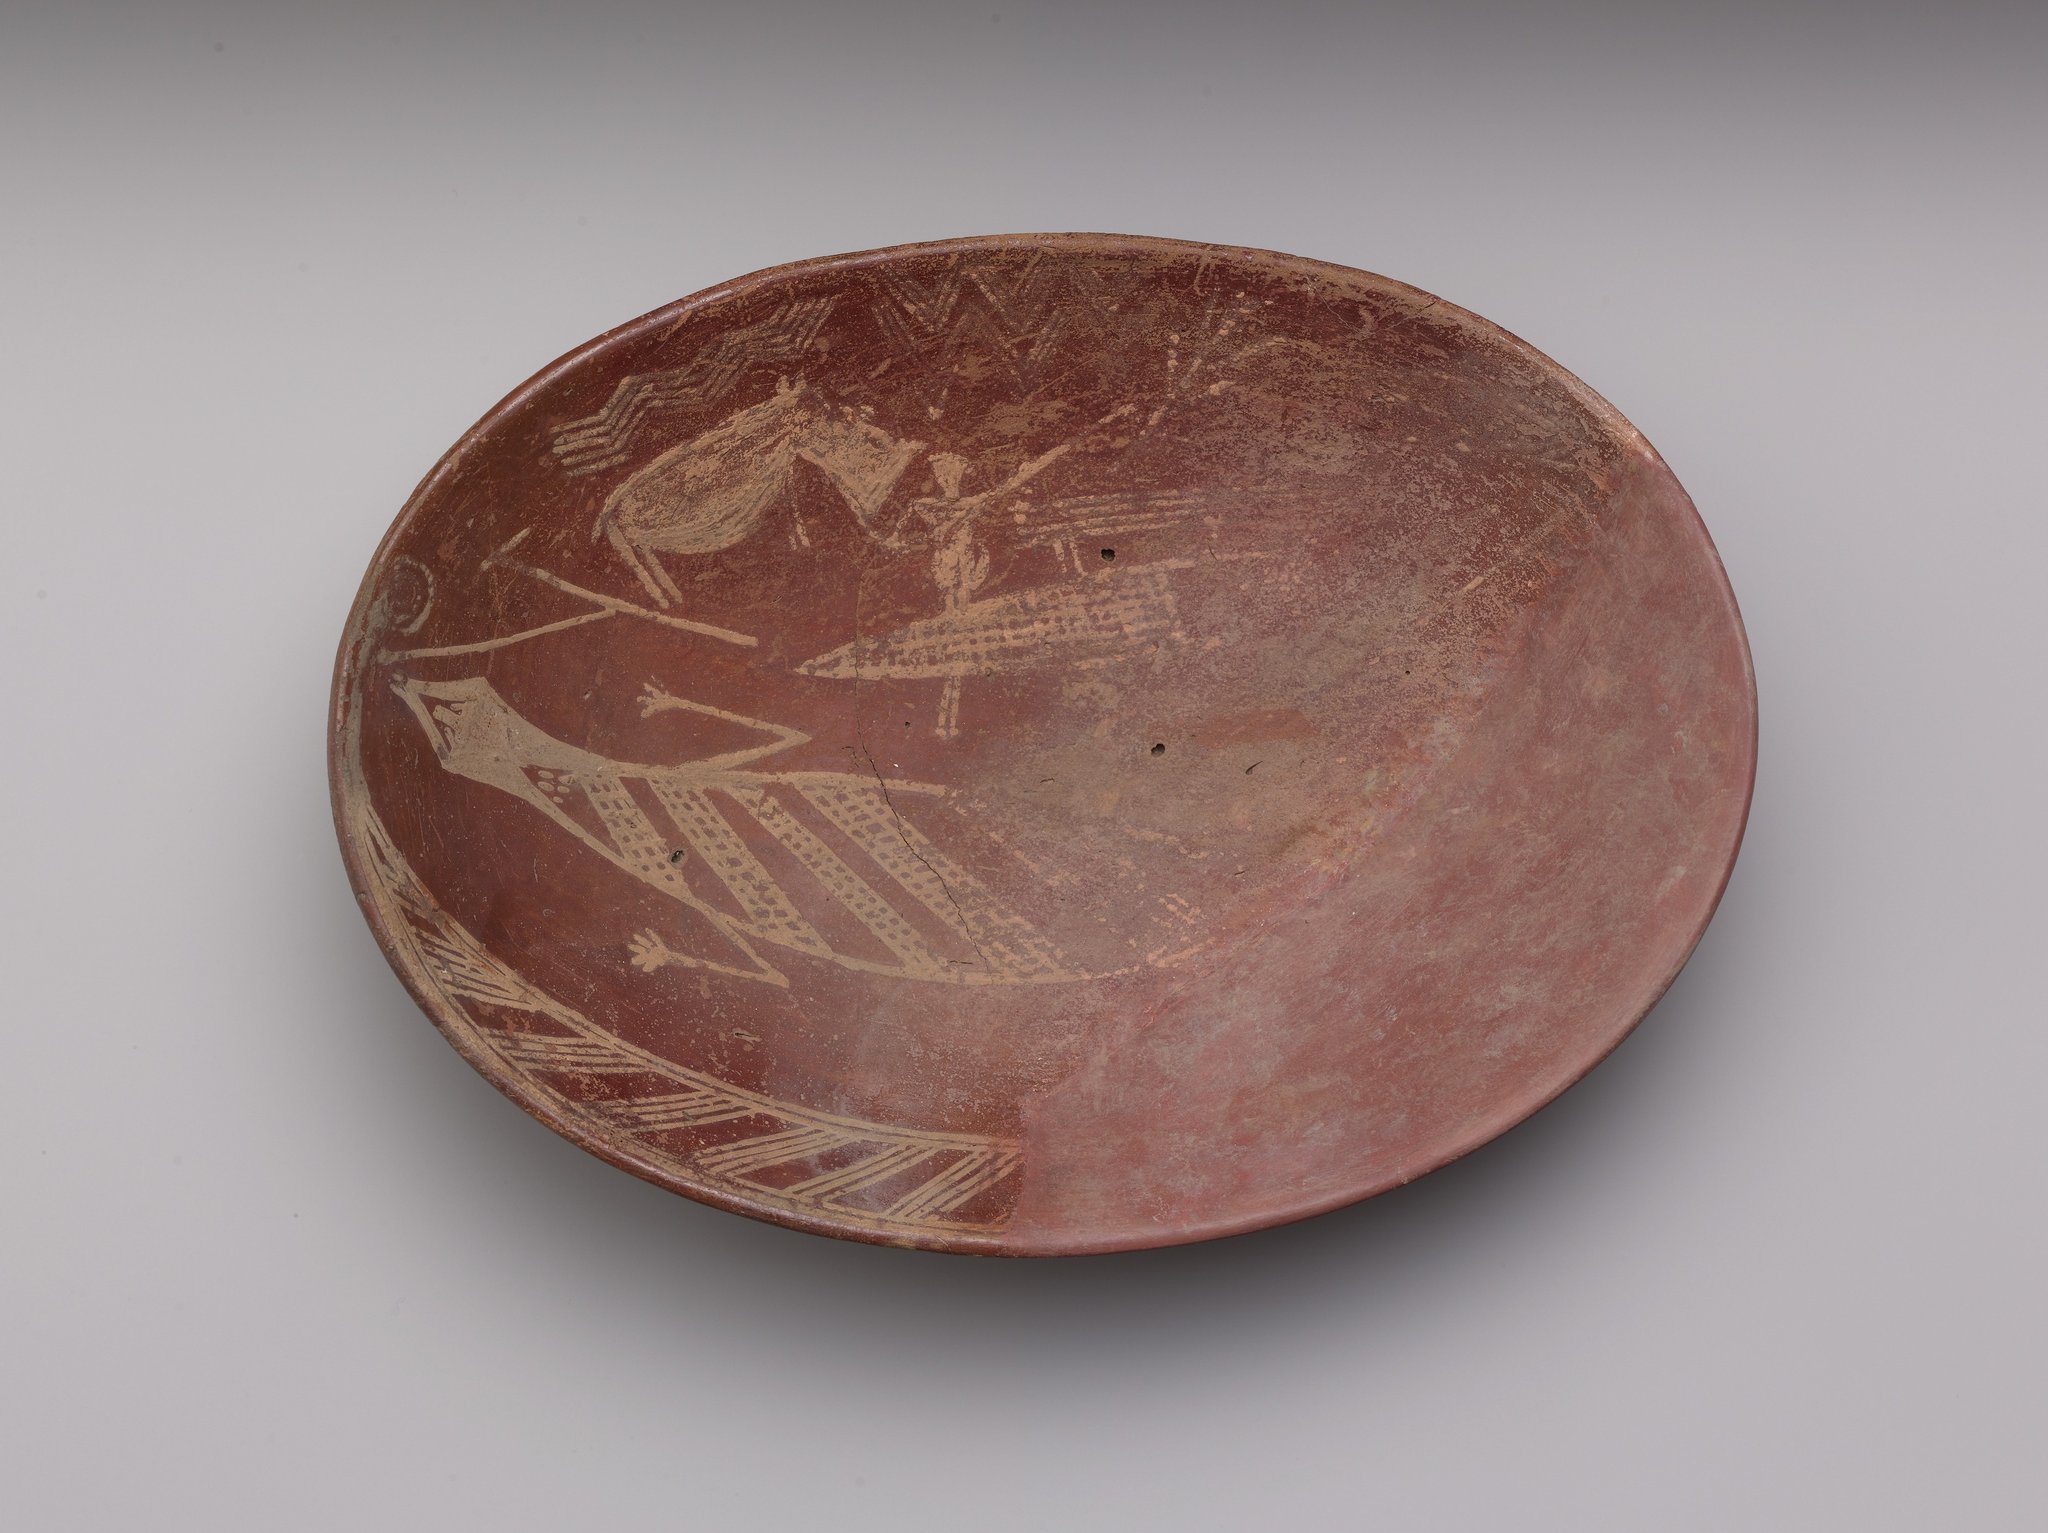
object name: bowl, white cross lined ware, man, hippo, crocodile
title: A shallow white cross-lined ware bowl illustrating a man on a boat alongside a hippo and crocodile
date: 3900-3650 BCE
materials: paint, pottery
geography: egypt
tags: men,crocodiles,hippos